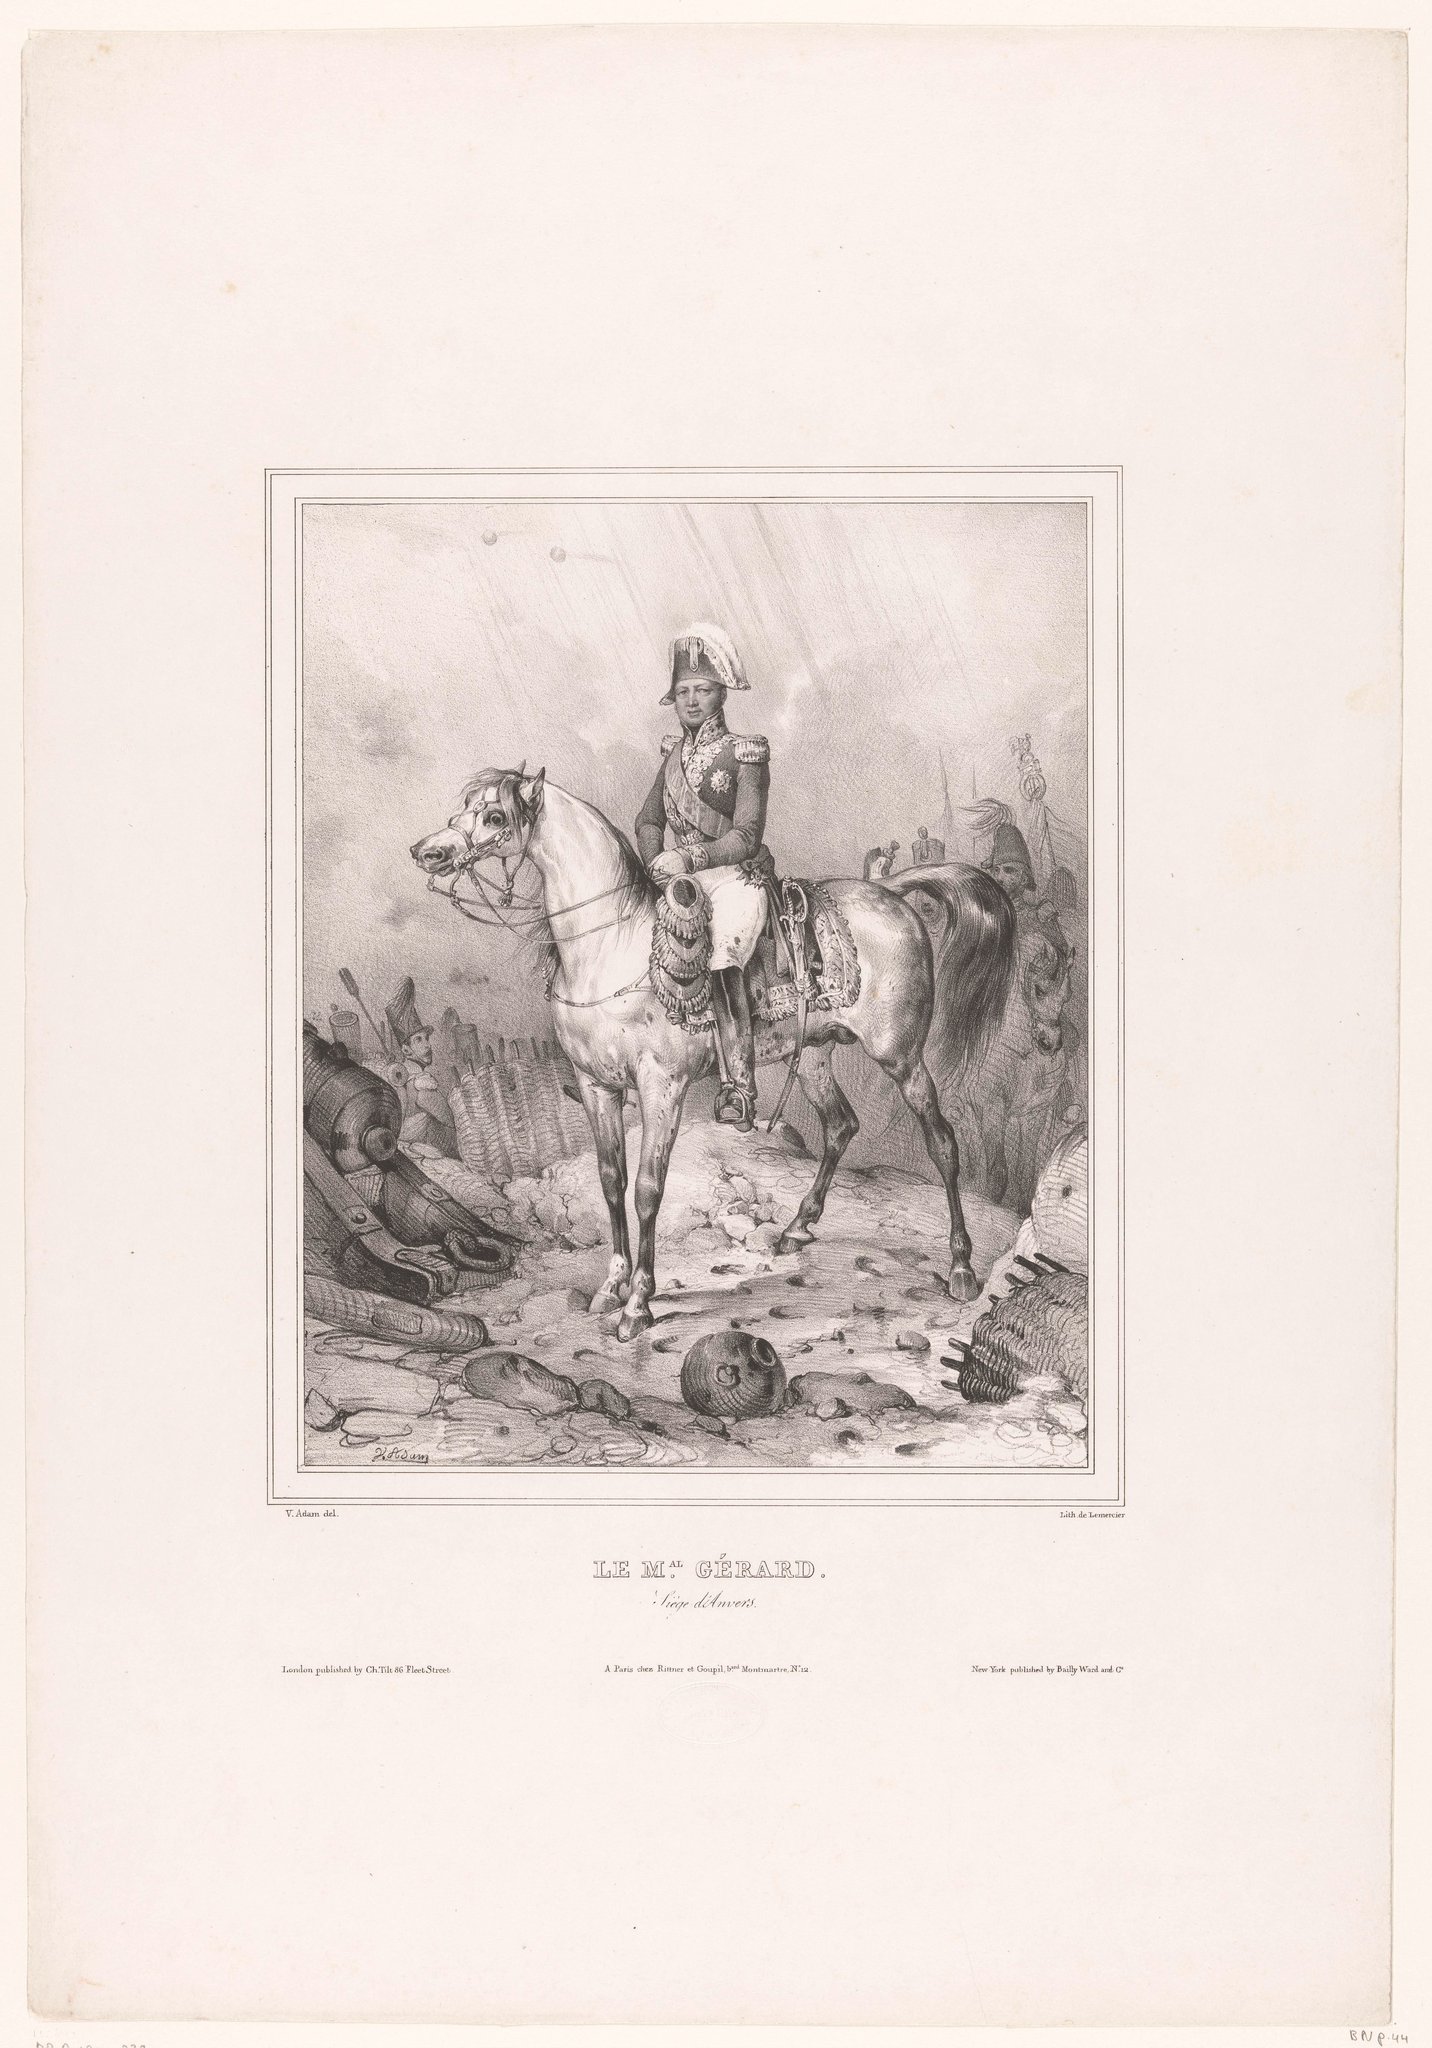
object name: print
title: Le m.al Gérard. Siège d'Anvers.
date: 1832-1833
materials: paper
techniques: lithography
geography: london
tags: equestrian state-portrait, historical persons, antwerp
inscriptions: collector's mark: Lugt 2228